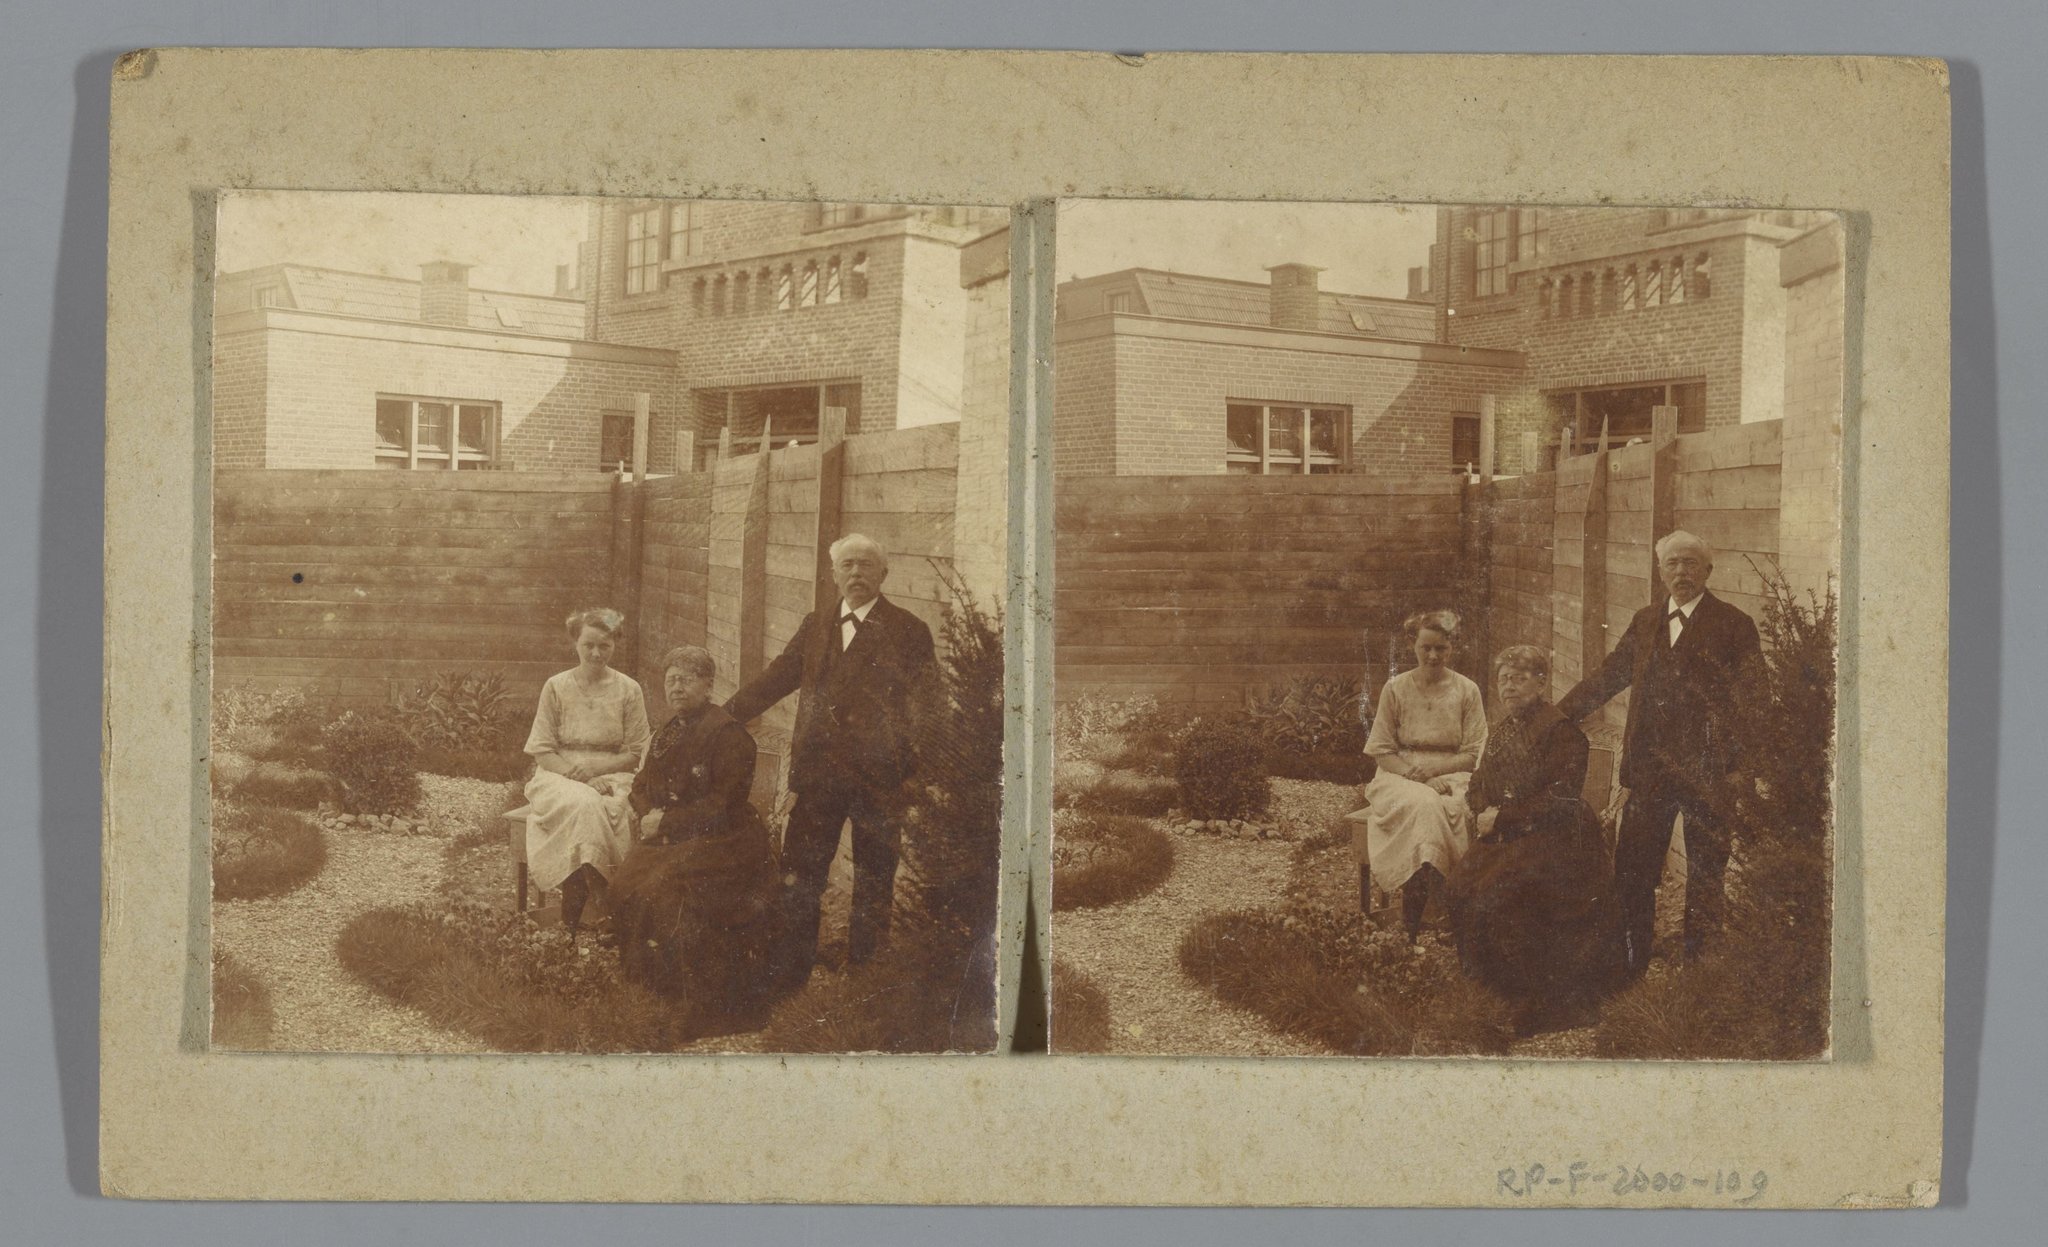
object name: stereograph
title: Twee vrouwen en een man in een tuin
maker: Anonymous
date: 1890-1930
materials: paper, cardboard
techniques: gelatin silver print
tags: garden